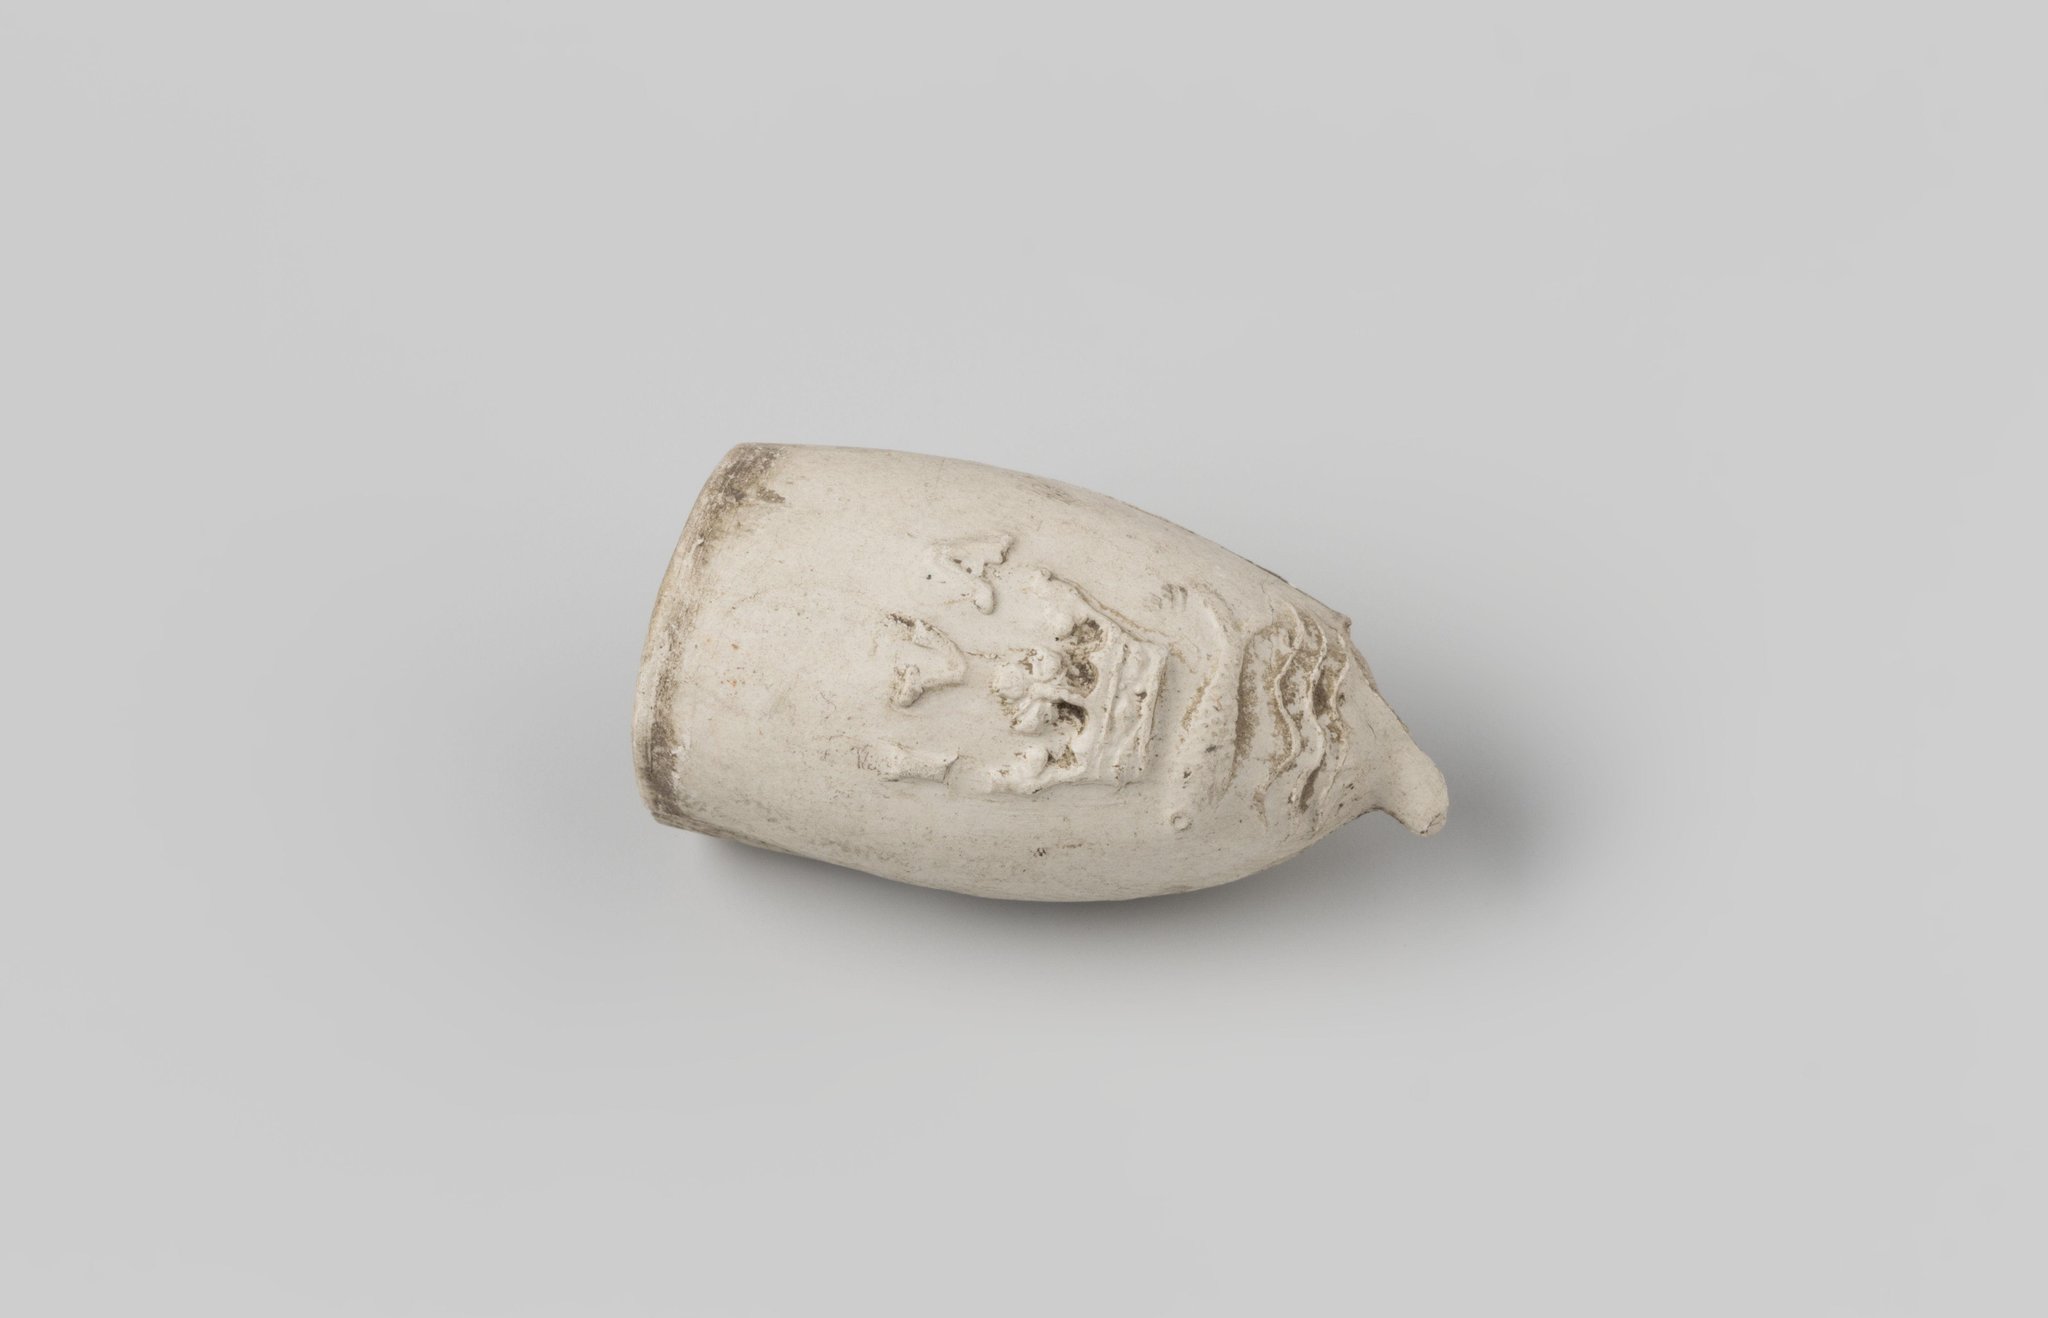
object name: fragment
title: Fragment pijpenkop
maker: jan van aten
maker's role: pijpenfabrikant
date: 1750-1780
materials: clay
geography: gorinchem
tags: directeur, hoogleraar, caspar jacob christiaan reuvens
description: Fragment pijpenkop met een kroon, een vis en drie golven, en de letters I V A afgebeeld. Van de opgravingen op de Hofstede Arentsburg 1827-1831 onder toezicht van Professor Reuvens.